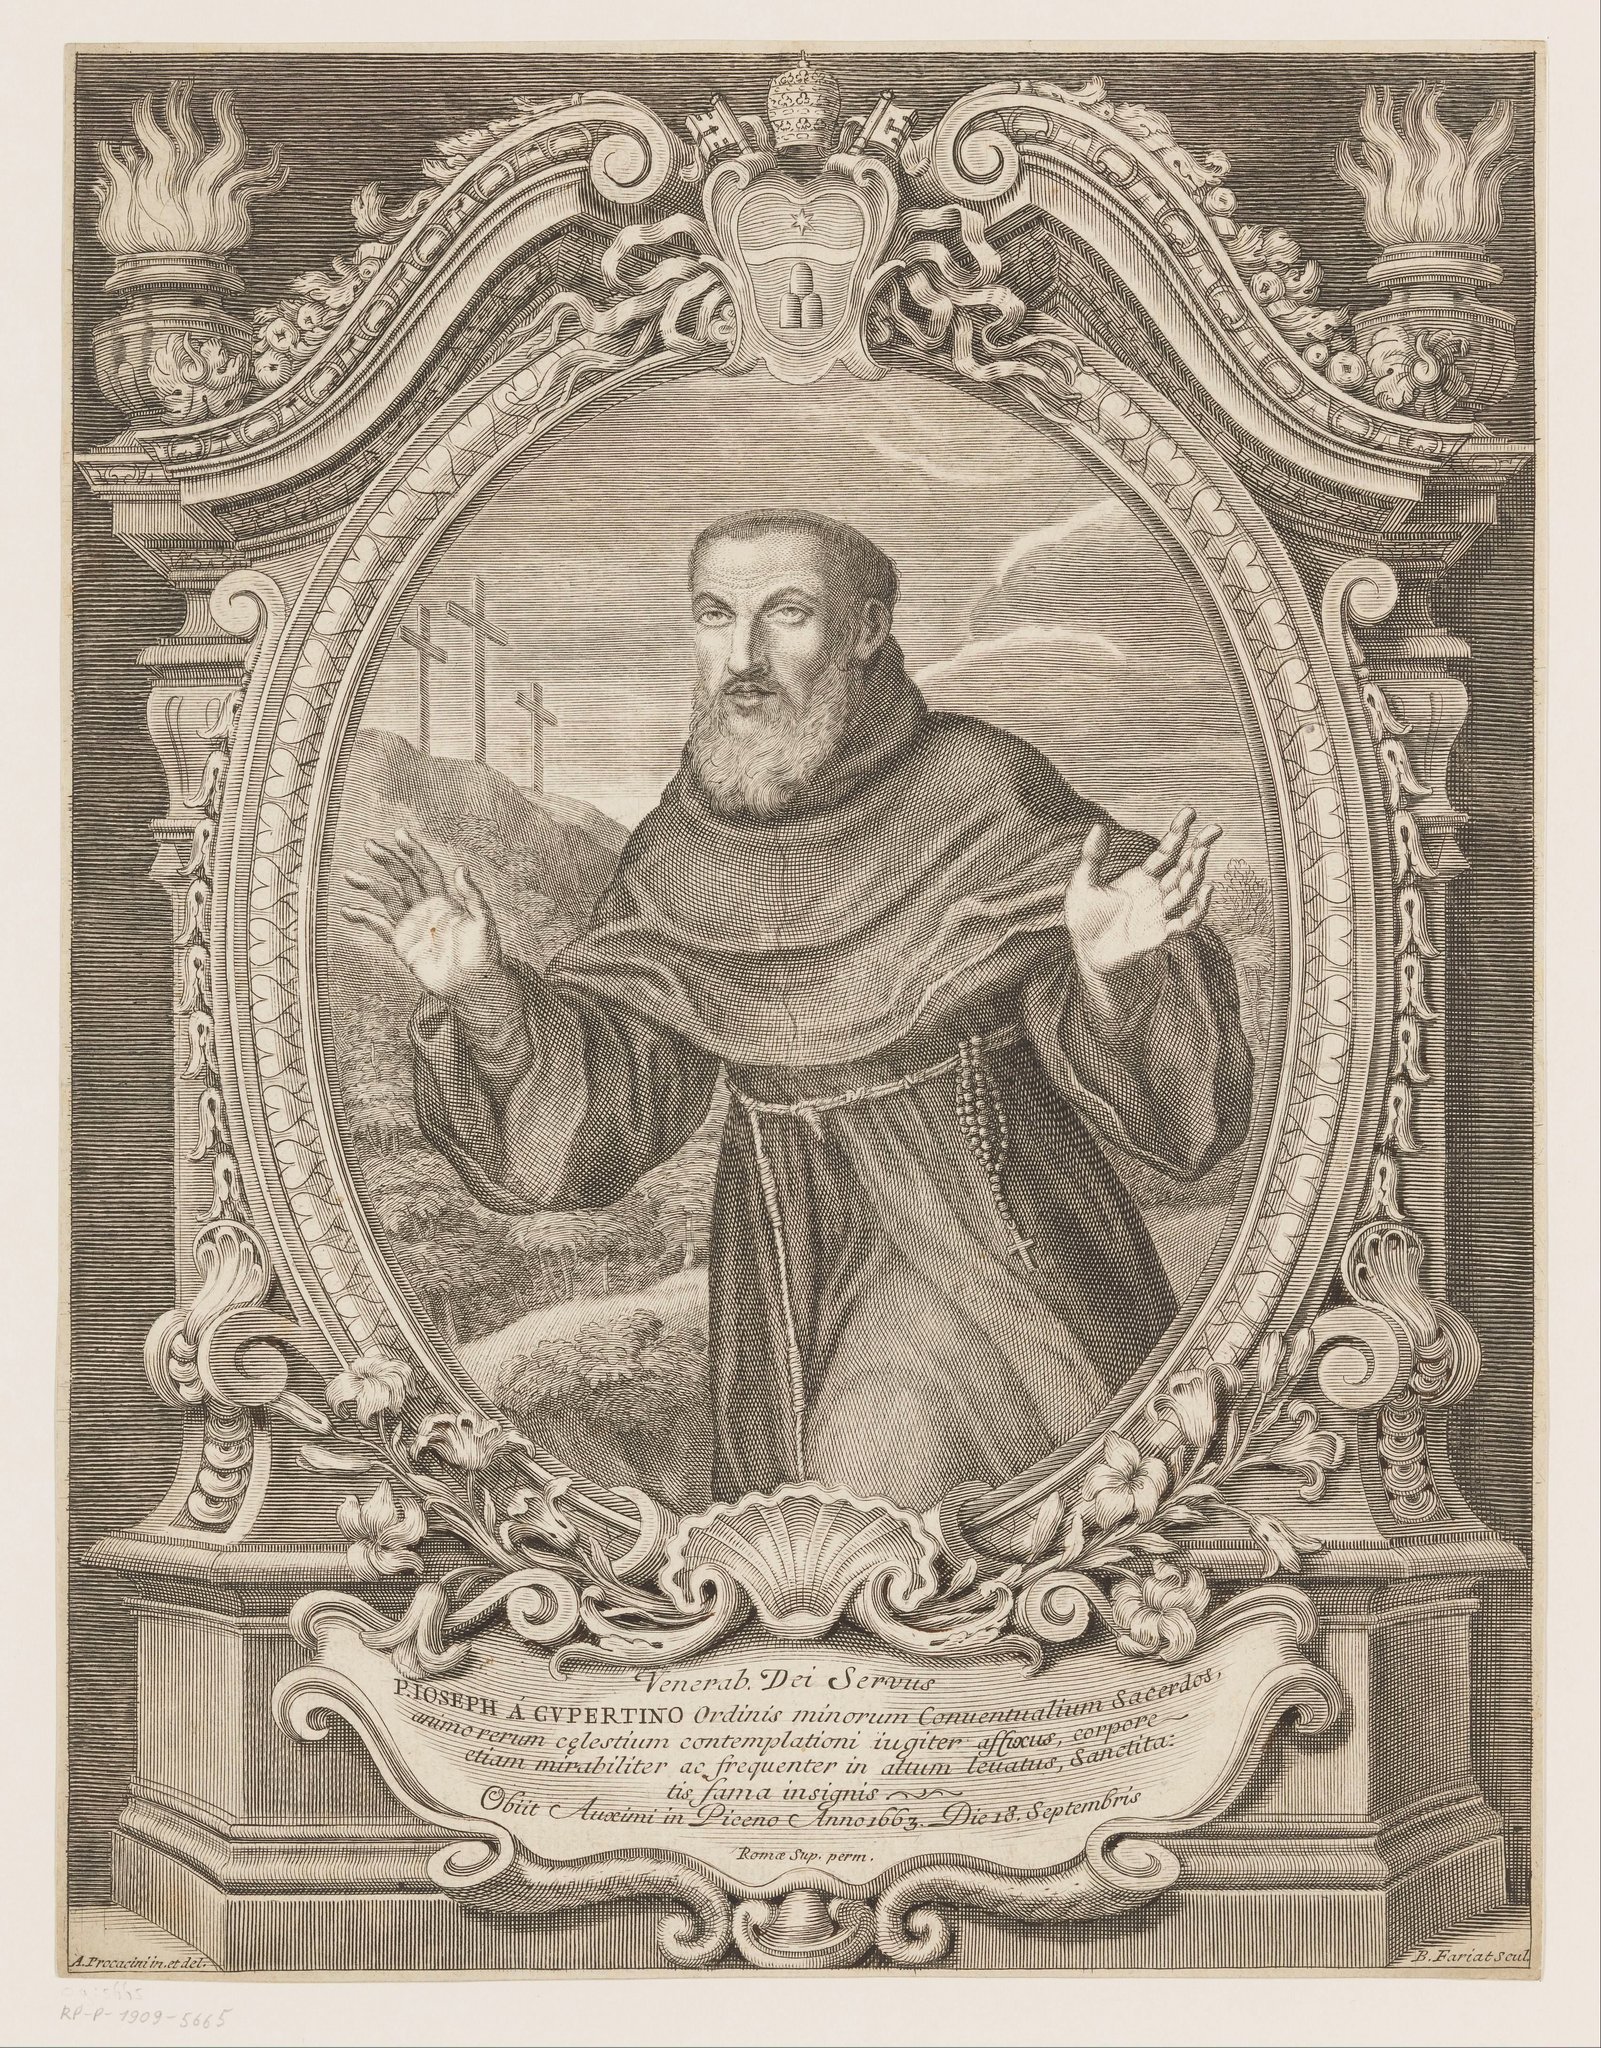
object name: print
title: P. Joseph á Cupertino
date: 1656-1720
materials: paper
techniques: engraving, etching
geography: france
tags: clergyman, historical persons, frame of painting, etc.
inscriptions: collector's mark: Lugt 2228